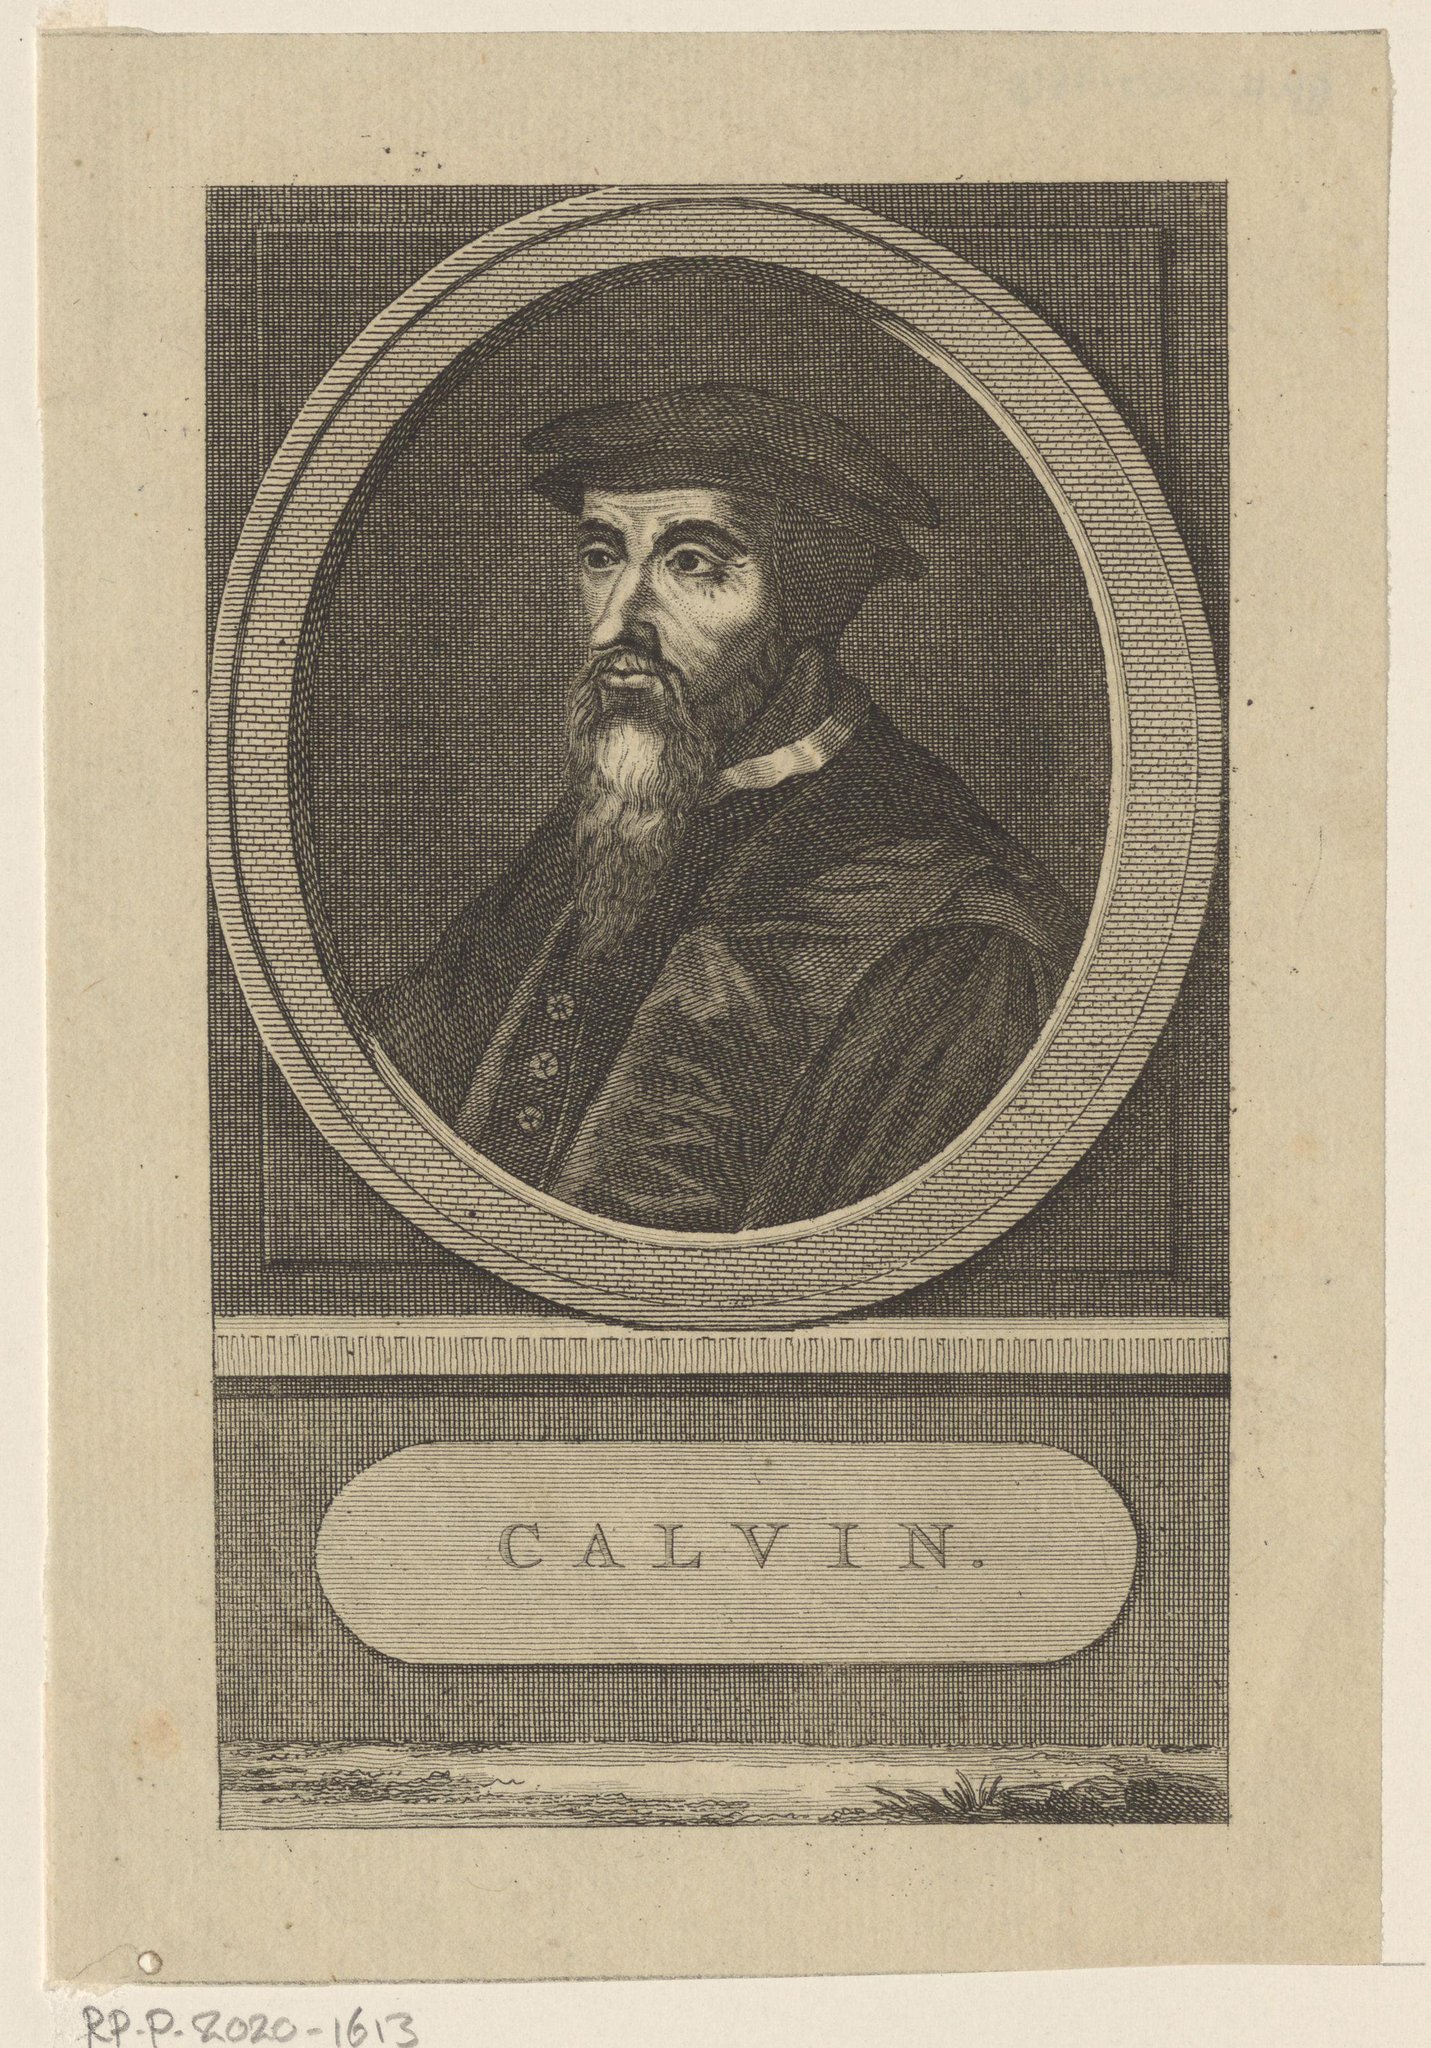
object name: print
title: Portret van Johannes Calvijn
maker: Anonymous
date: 1650-1749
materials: paper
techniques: engraving, etching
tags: historical persons